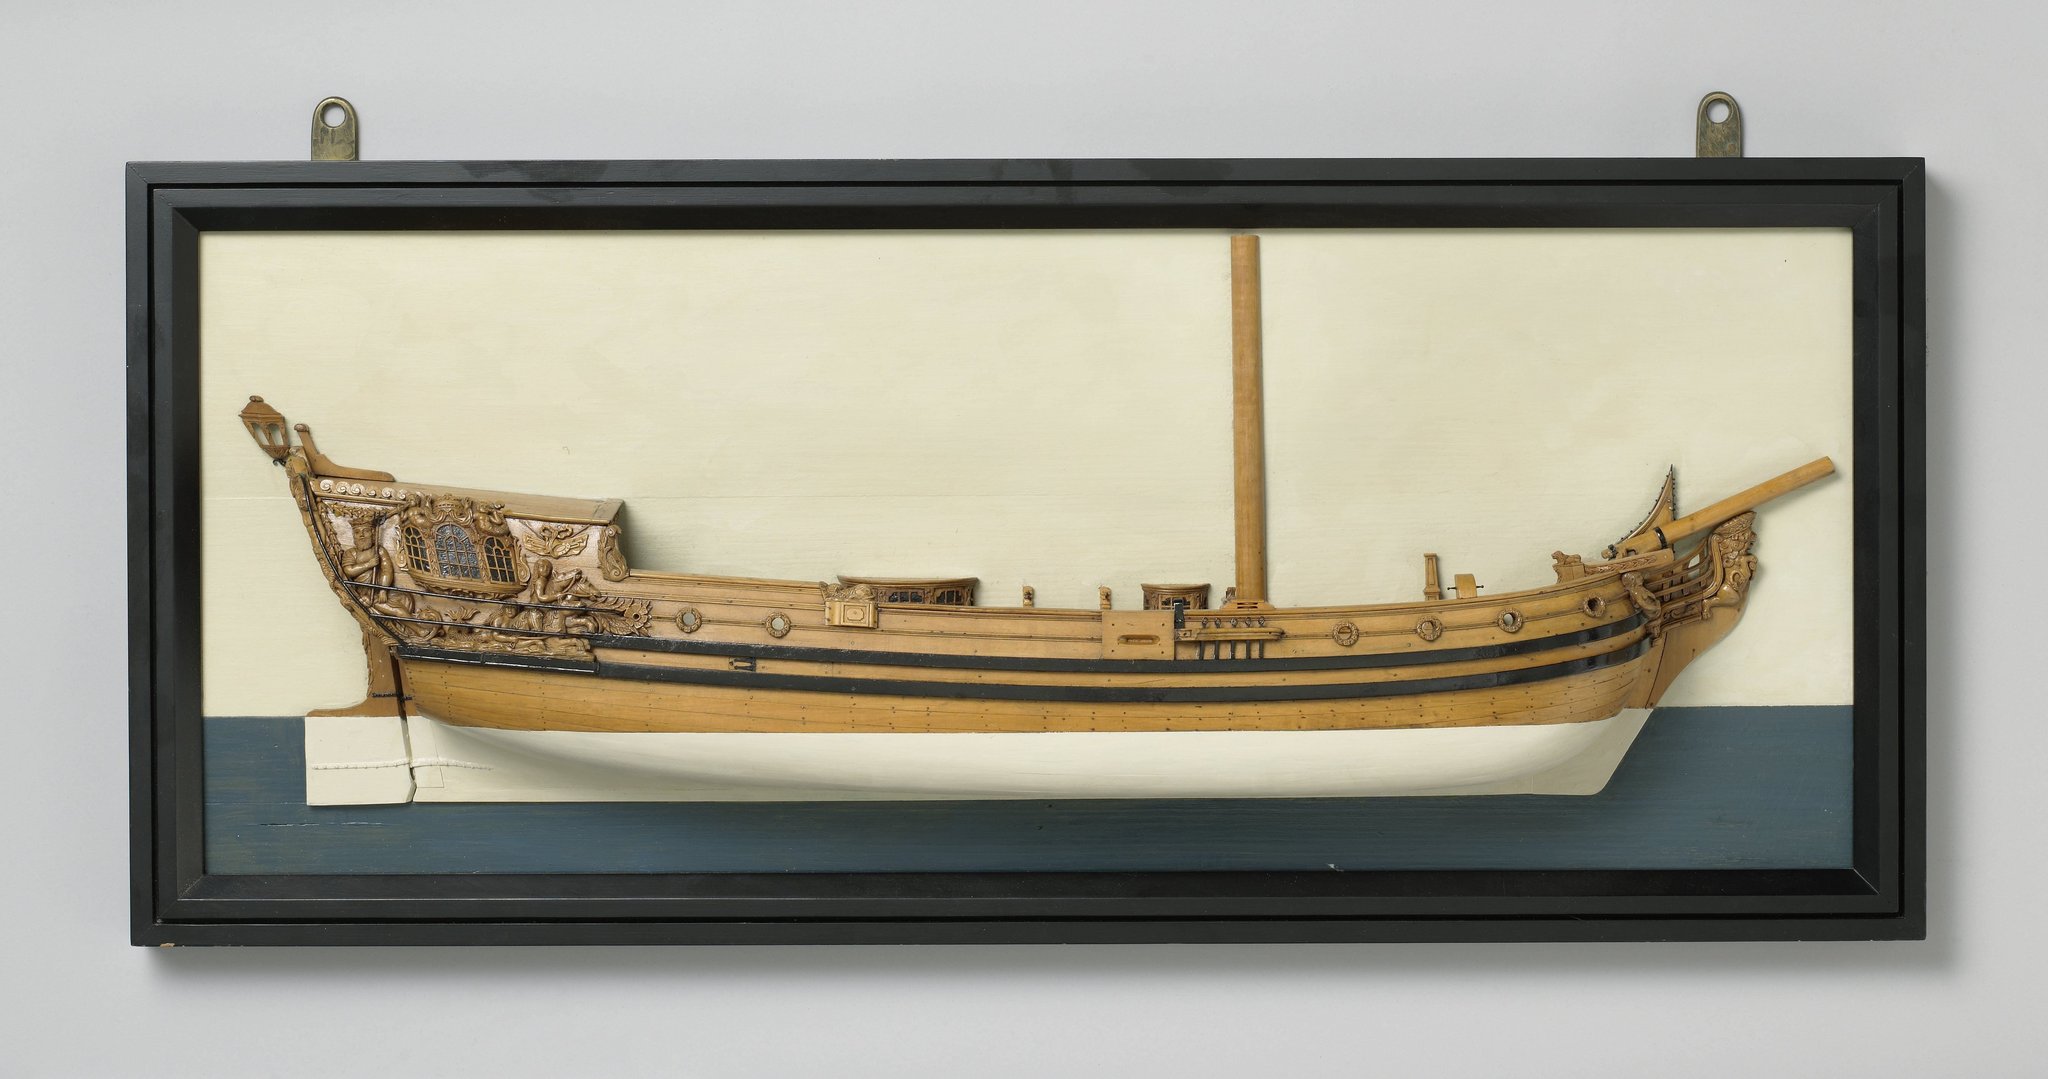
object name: ship model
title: Half Model of an Admiralty Yacht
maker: Anonymous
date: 1725-1790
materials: brass, wood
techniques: polychromy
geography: netherlands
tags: amsterdam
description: Dit jacht was bestemd voor de Admiraliteit van Amsterdam.